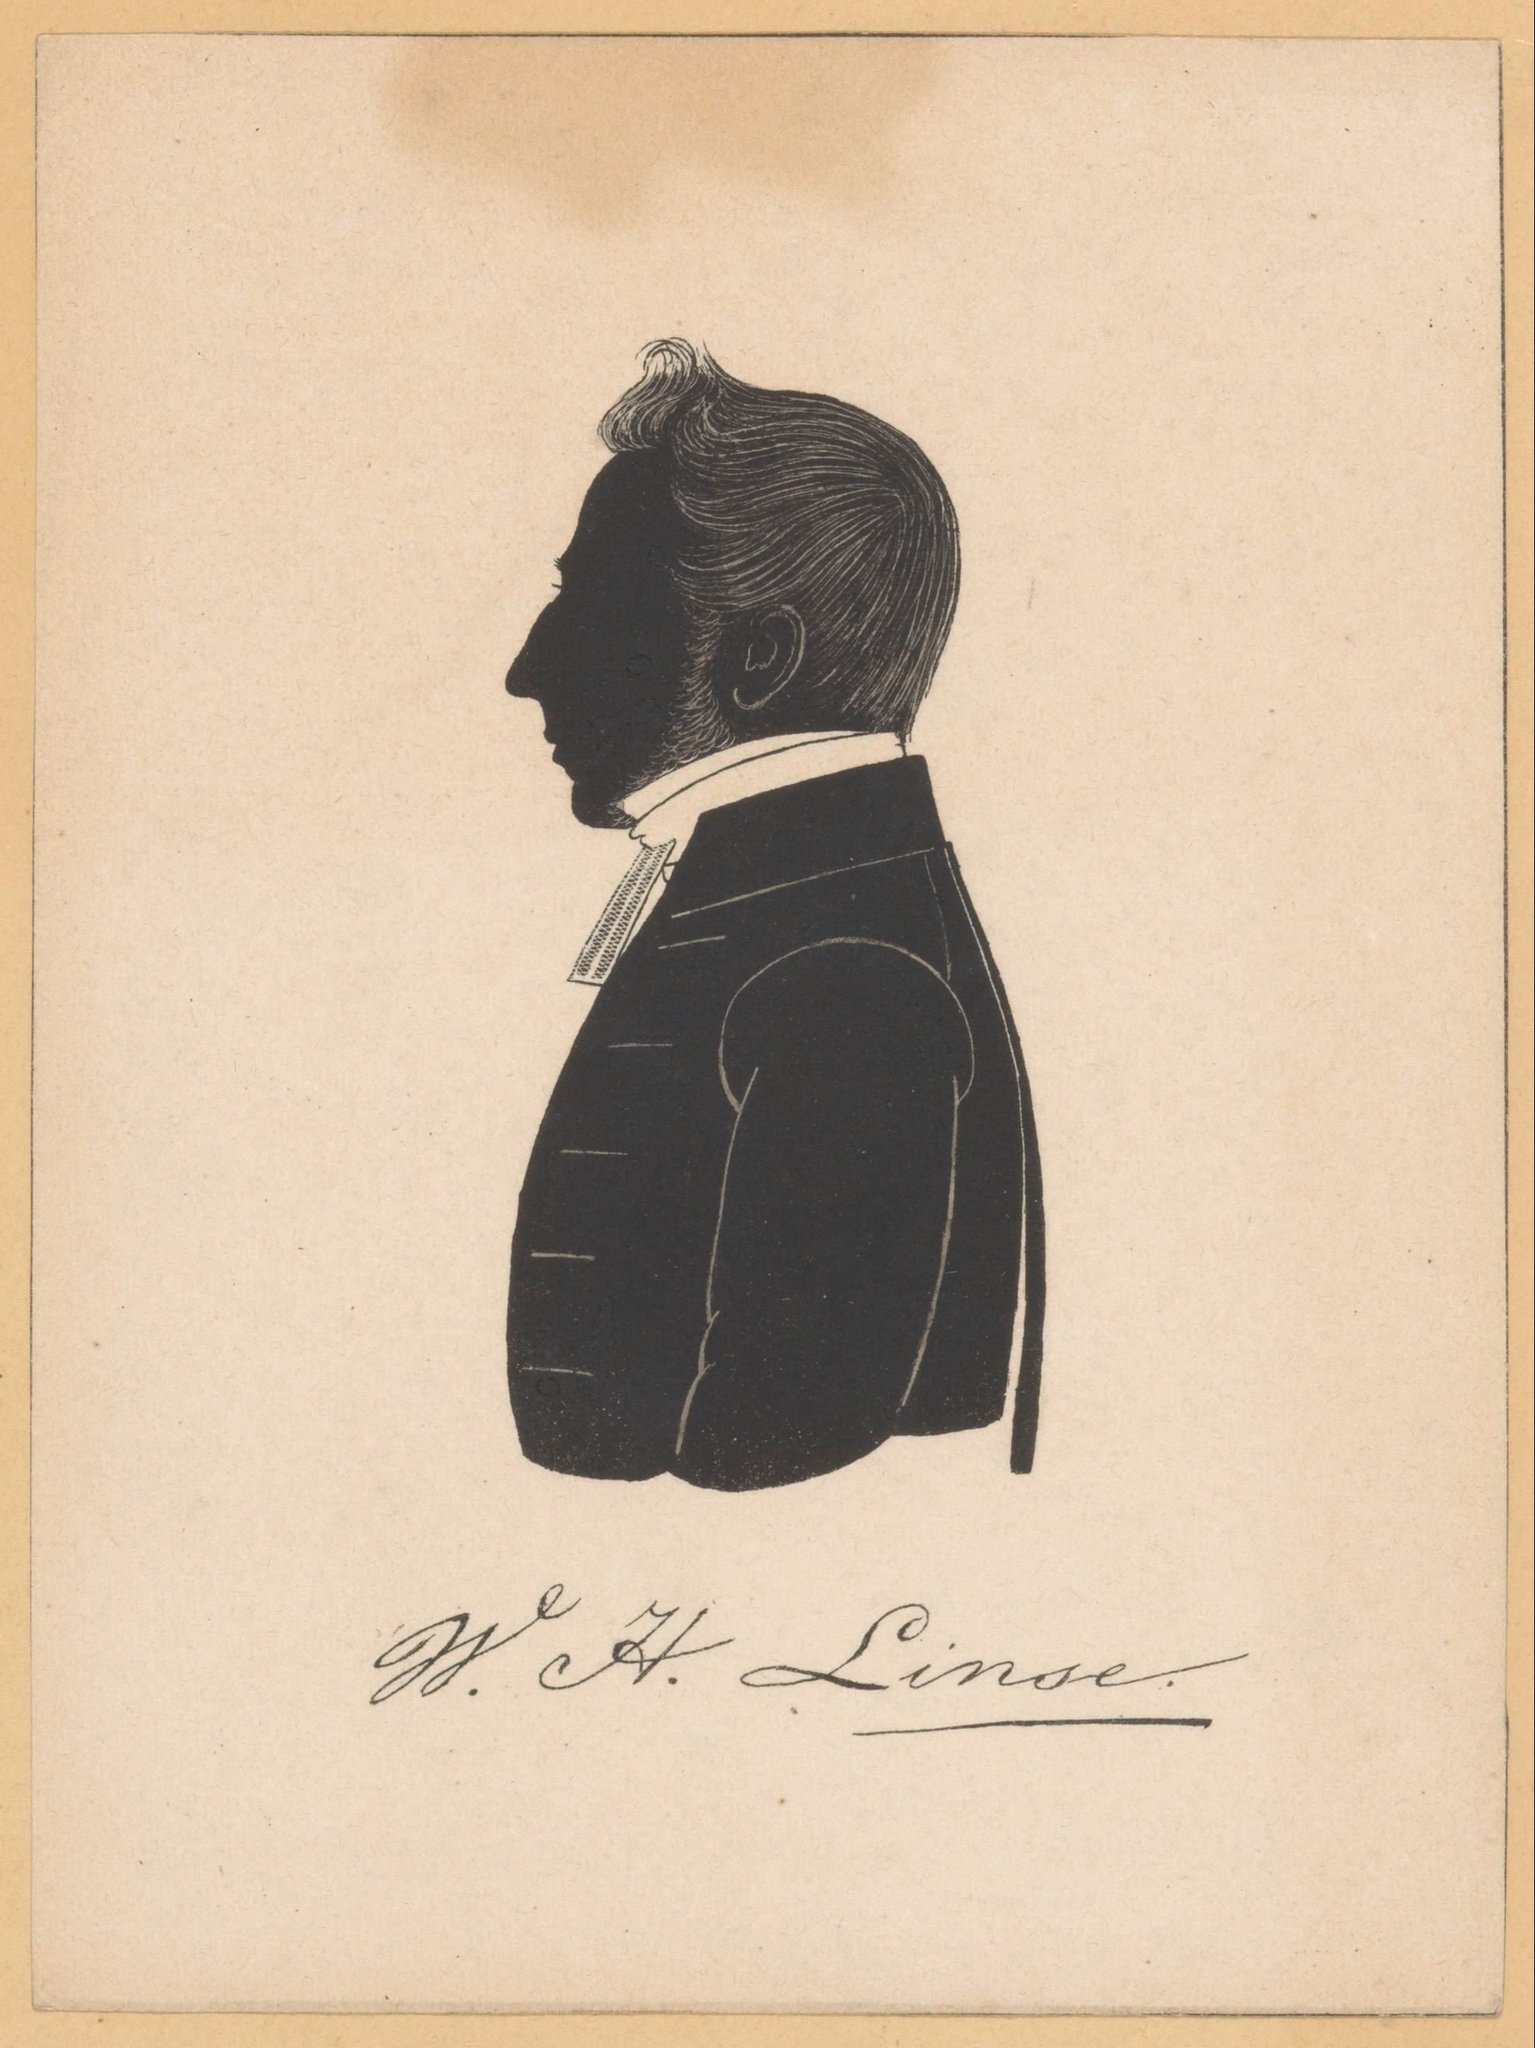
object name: print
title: Silhouetportret van W.H. Linse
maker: pieter barbiers (iv)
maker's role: painter, print maker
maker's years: 1798-1848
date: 1809-1848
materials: paper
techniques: hand coloring, lithograph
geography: netherlands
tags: historical persons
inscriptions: collector's mark: Lugt 2228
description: Onder het portret de signatuur van de geportretteerde.